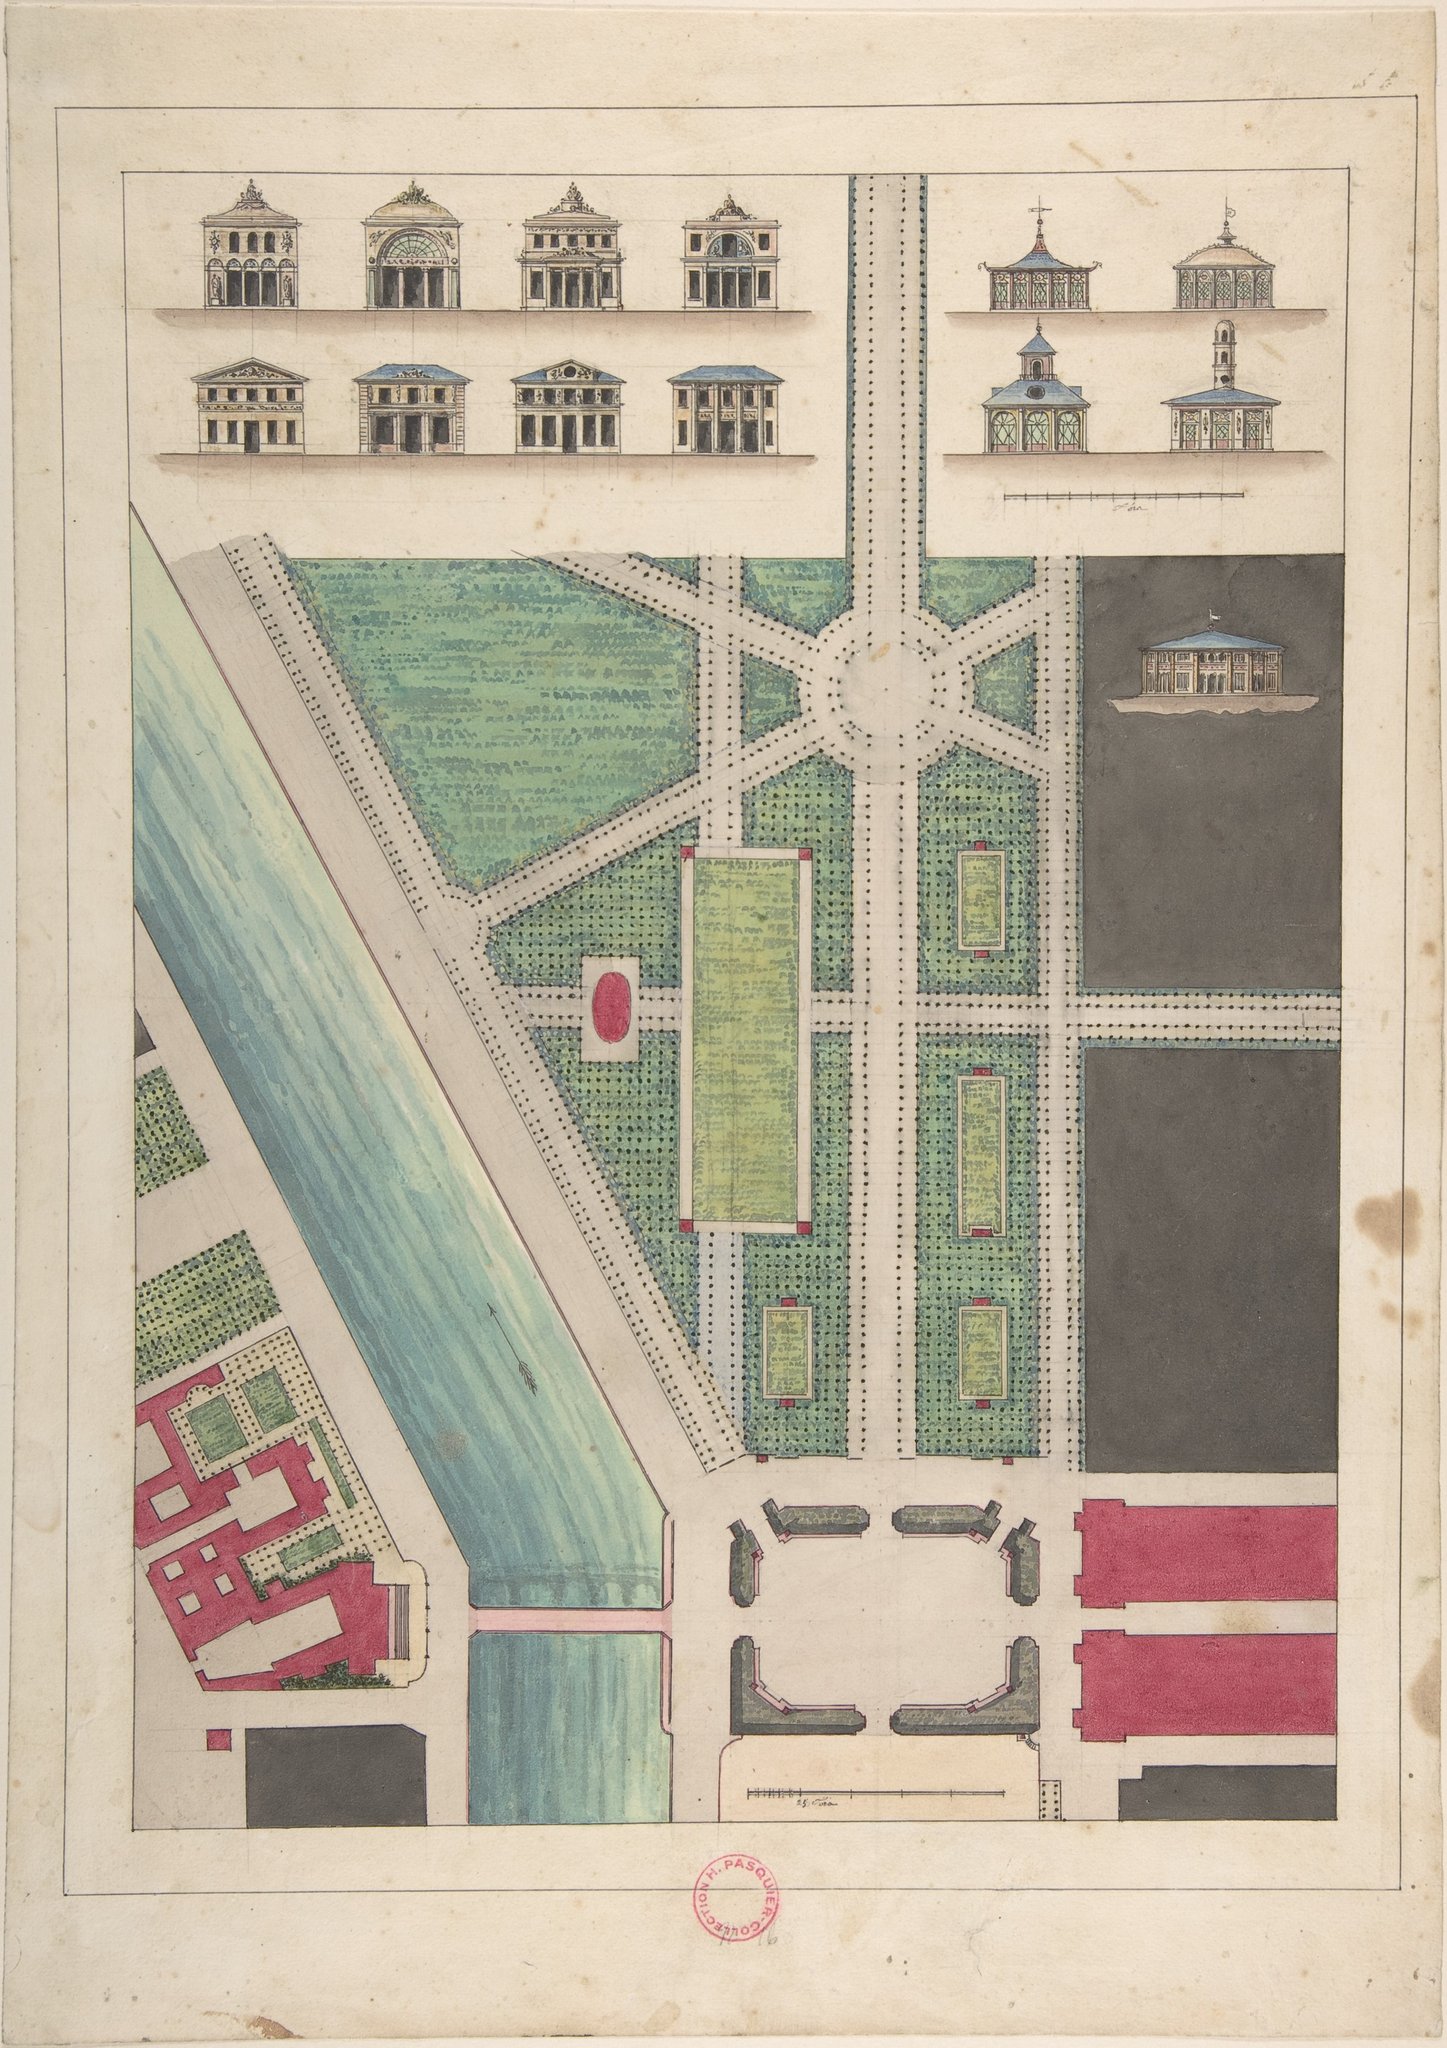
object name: drawing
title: Jardin Public, Champs Elysées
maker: gabriel thouin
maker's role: artist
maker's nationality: french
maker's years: 1747-1829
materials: graphite, ink, watercolor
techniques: brush, pen, drawing, wash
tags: architecture,gardens